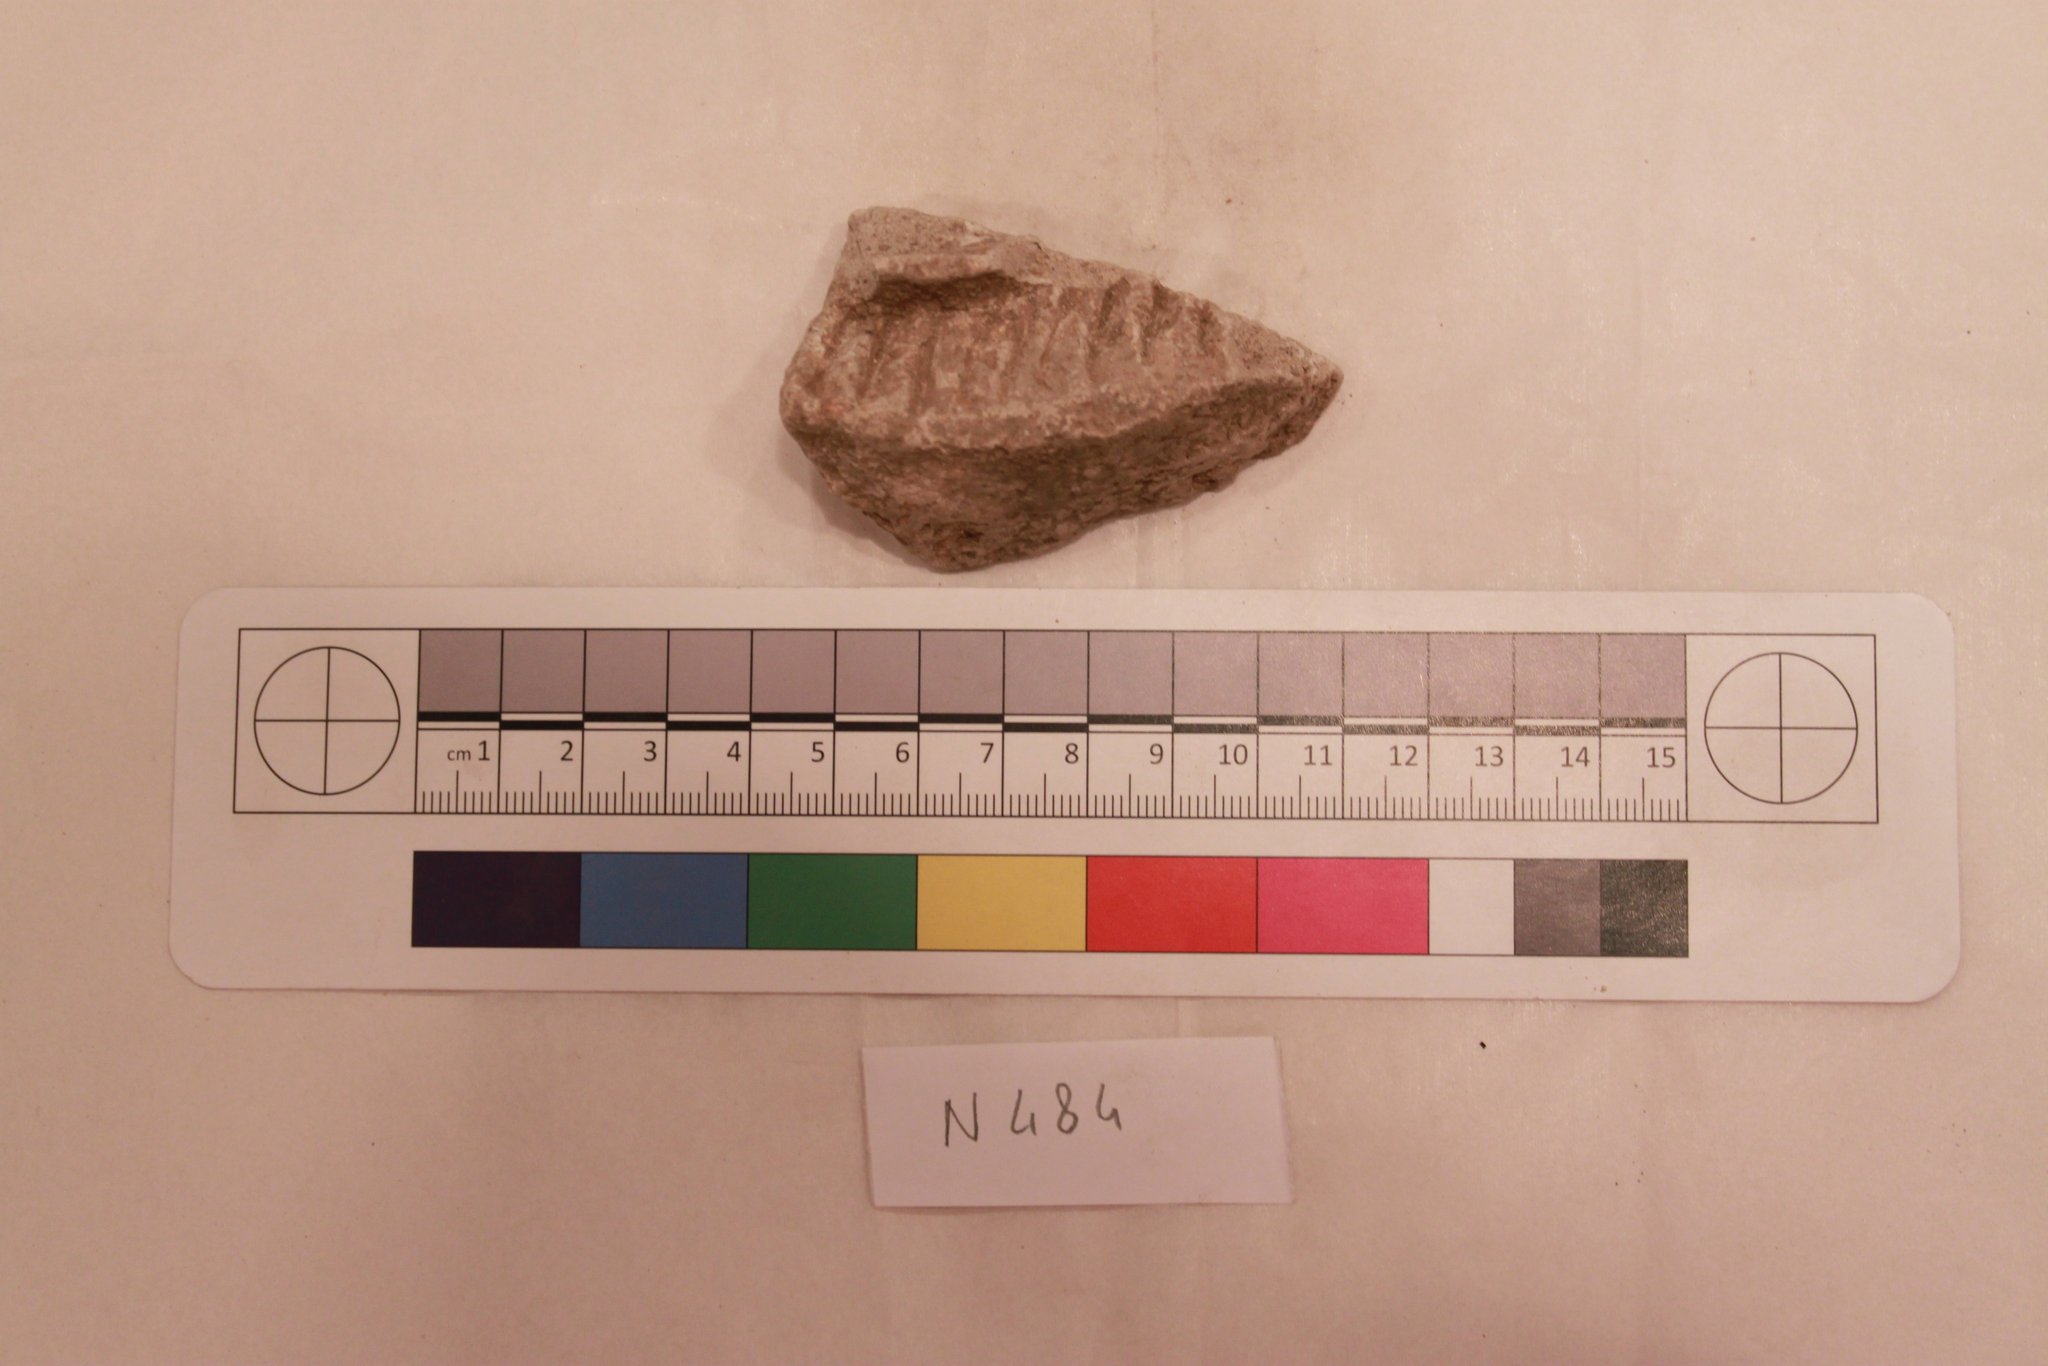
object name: fragment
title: Stucco Fragment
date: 701-1200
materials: plaster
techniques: carving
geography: iran